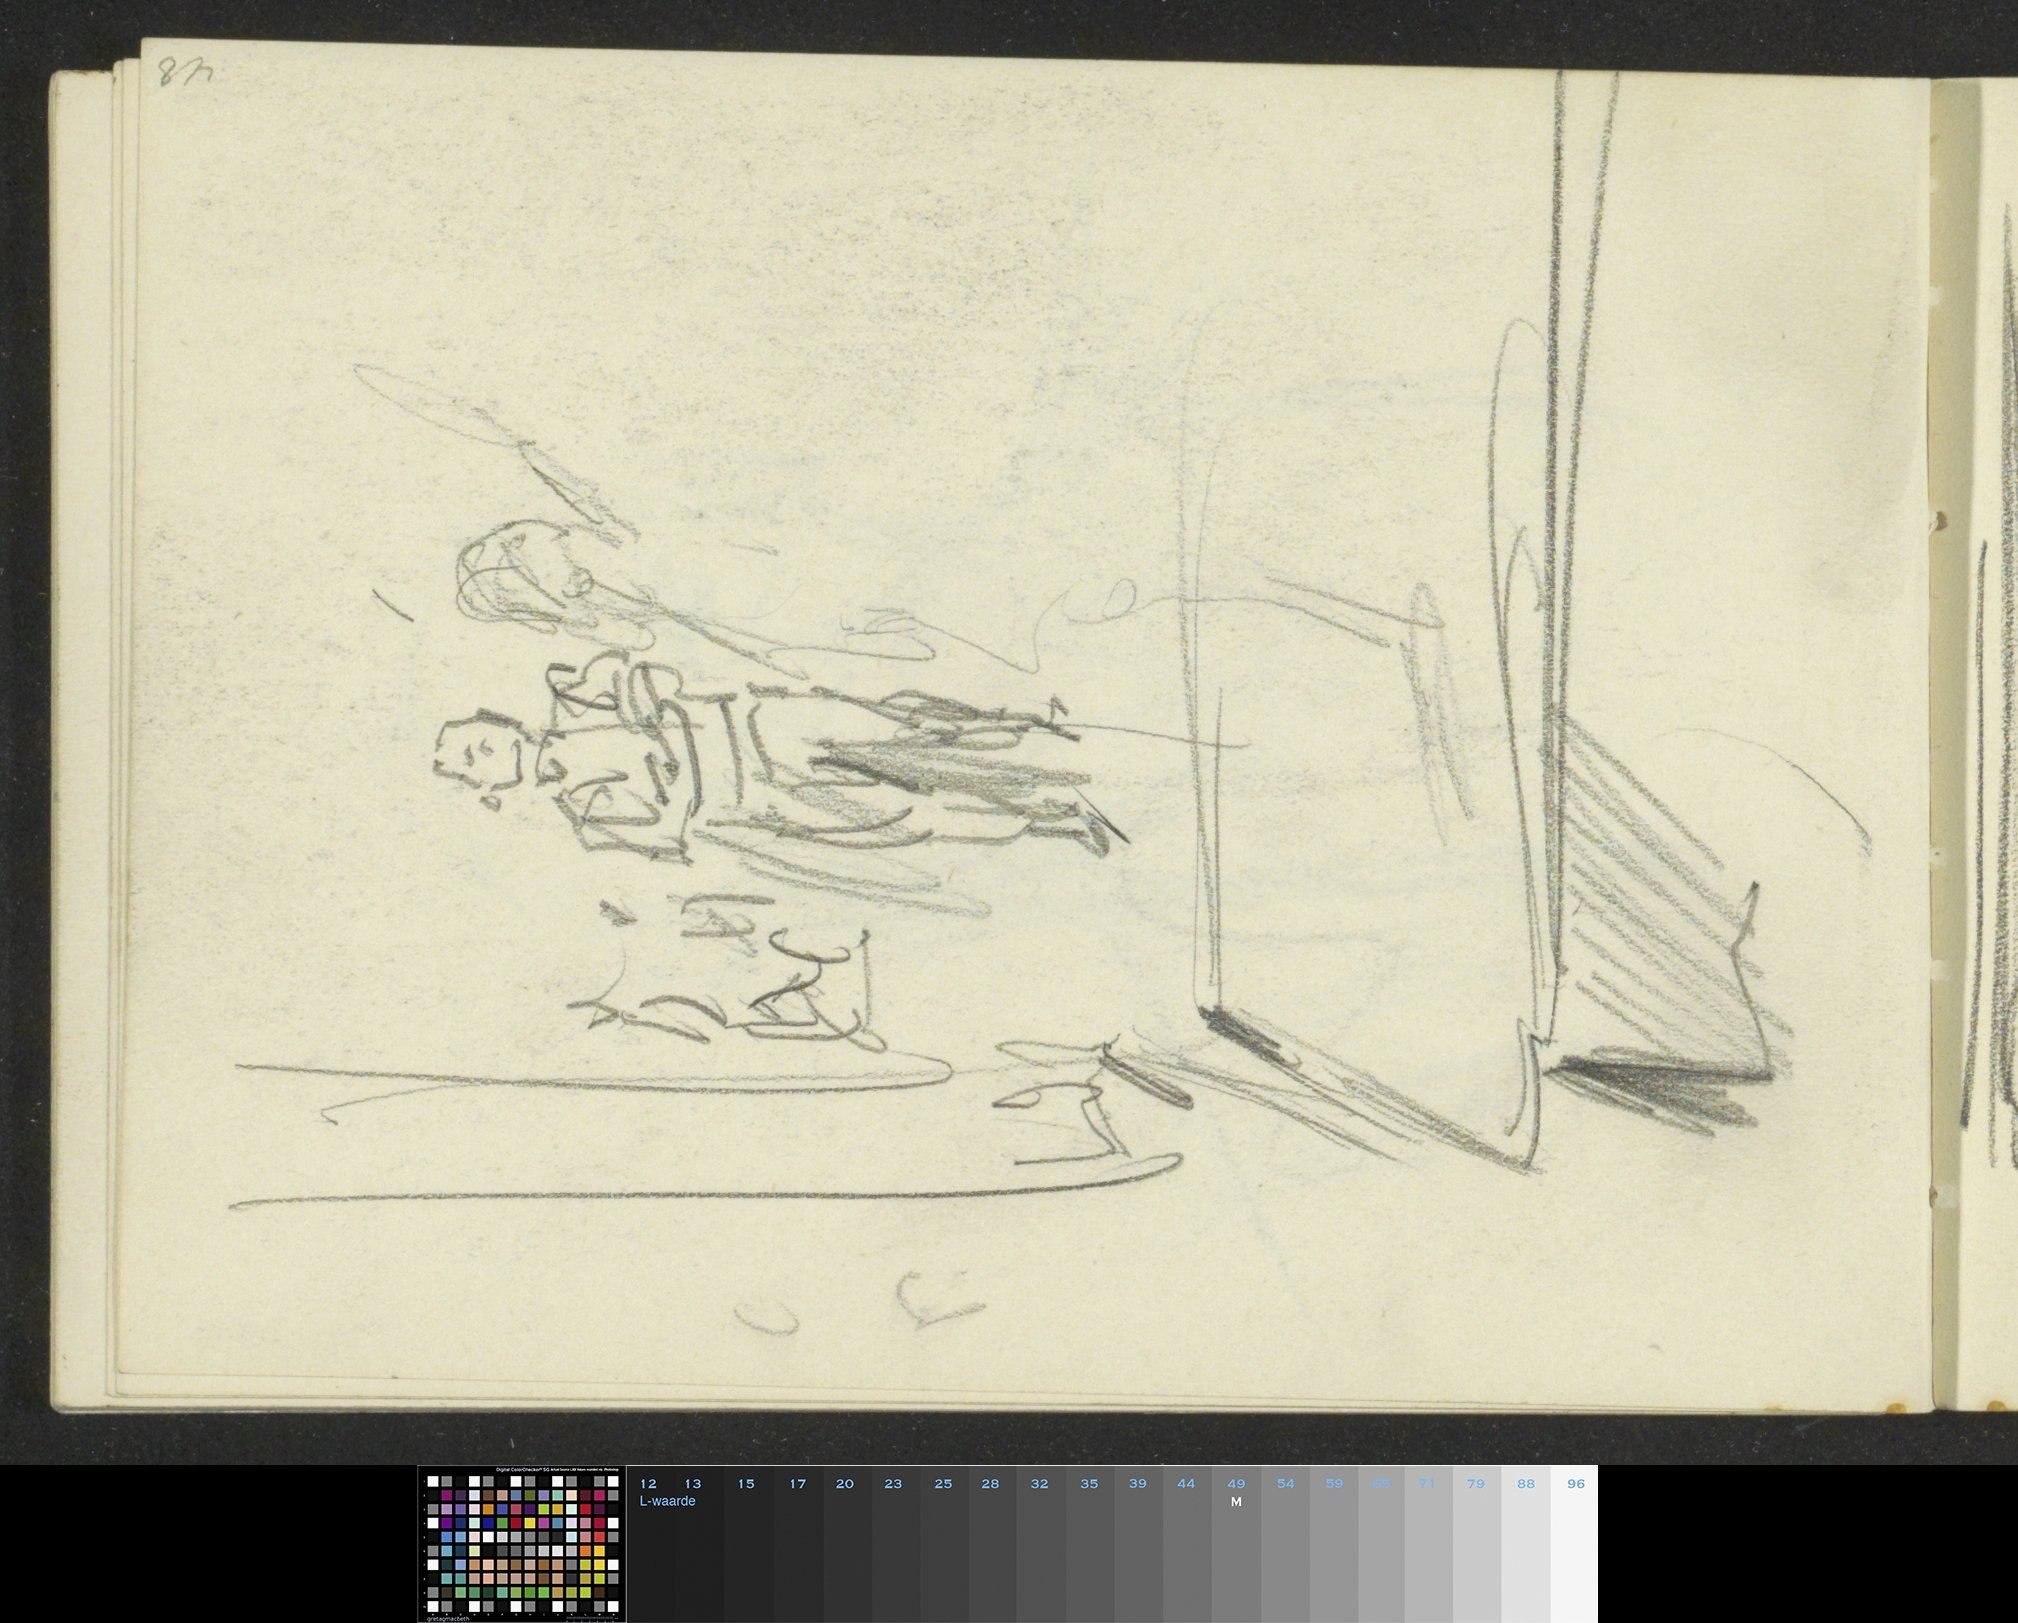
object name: sketchbook leaf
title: Figuren, mogelijk artiesten op een podium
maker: isaac israels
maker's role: draughtsman, painter, print maker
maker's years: 1865-1934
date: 1875-1934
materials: paper, pencil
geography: the hague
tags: performance, the (nude) human figure; 'corpo humano' (ripa), the stage and its equipment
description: Blad 11 verso uit schetsboek LVII met 29 bladen.